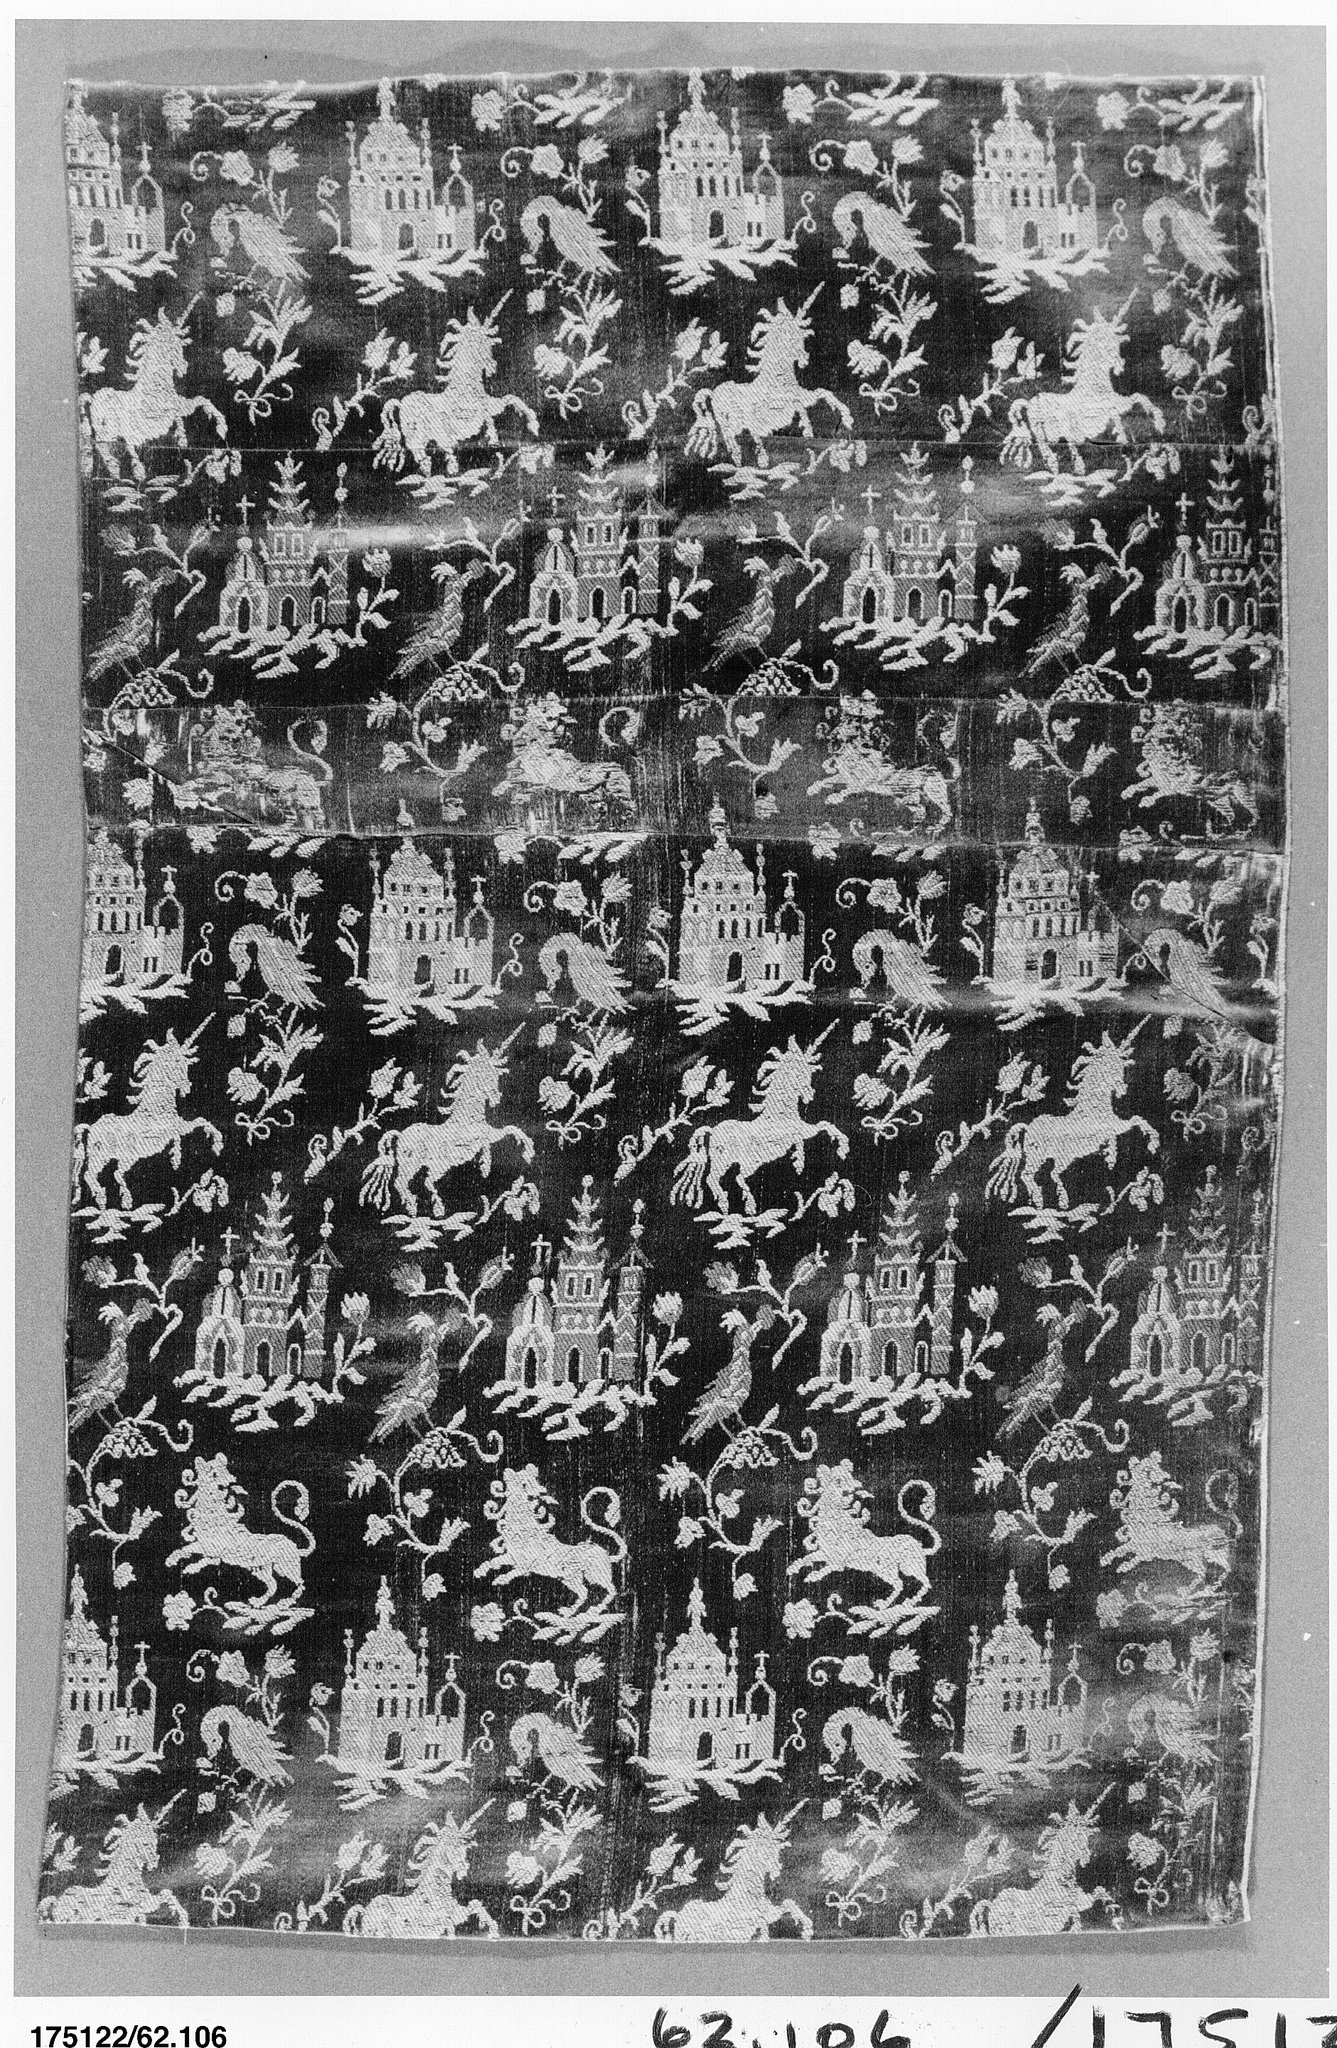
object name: piece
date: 1701-1733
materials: silk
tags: birds,buildings,unicorns